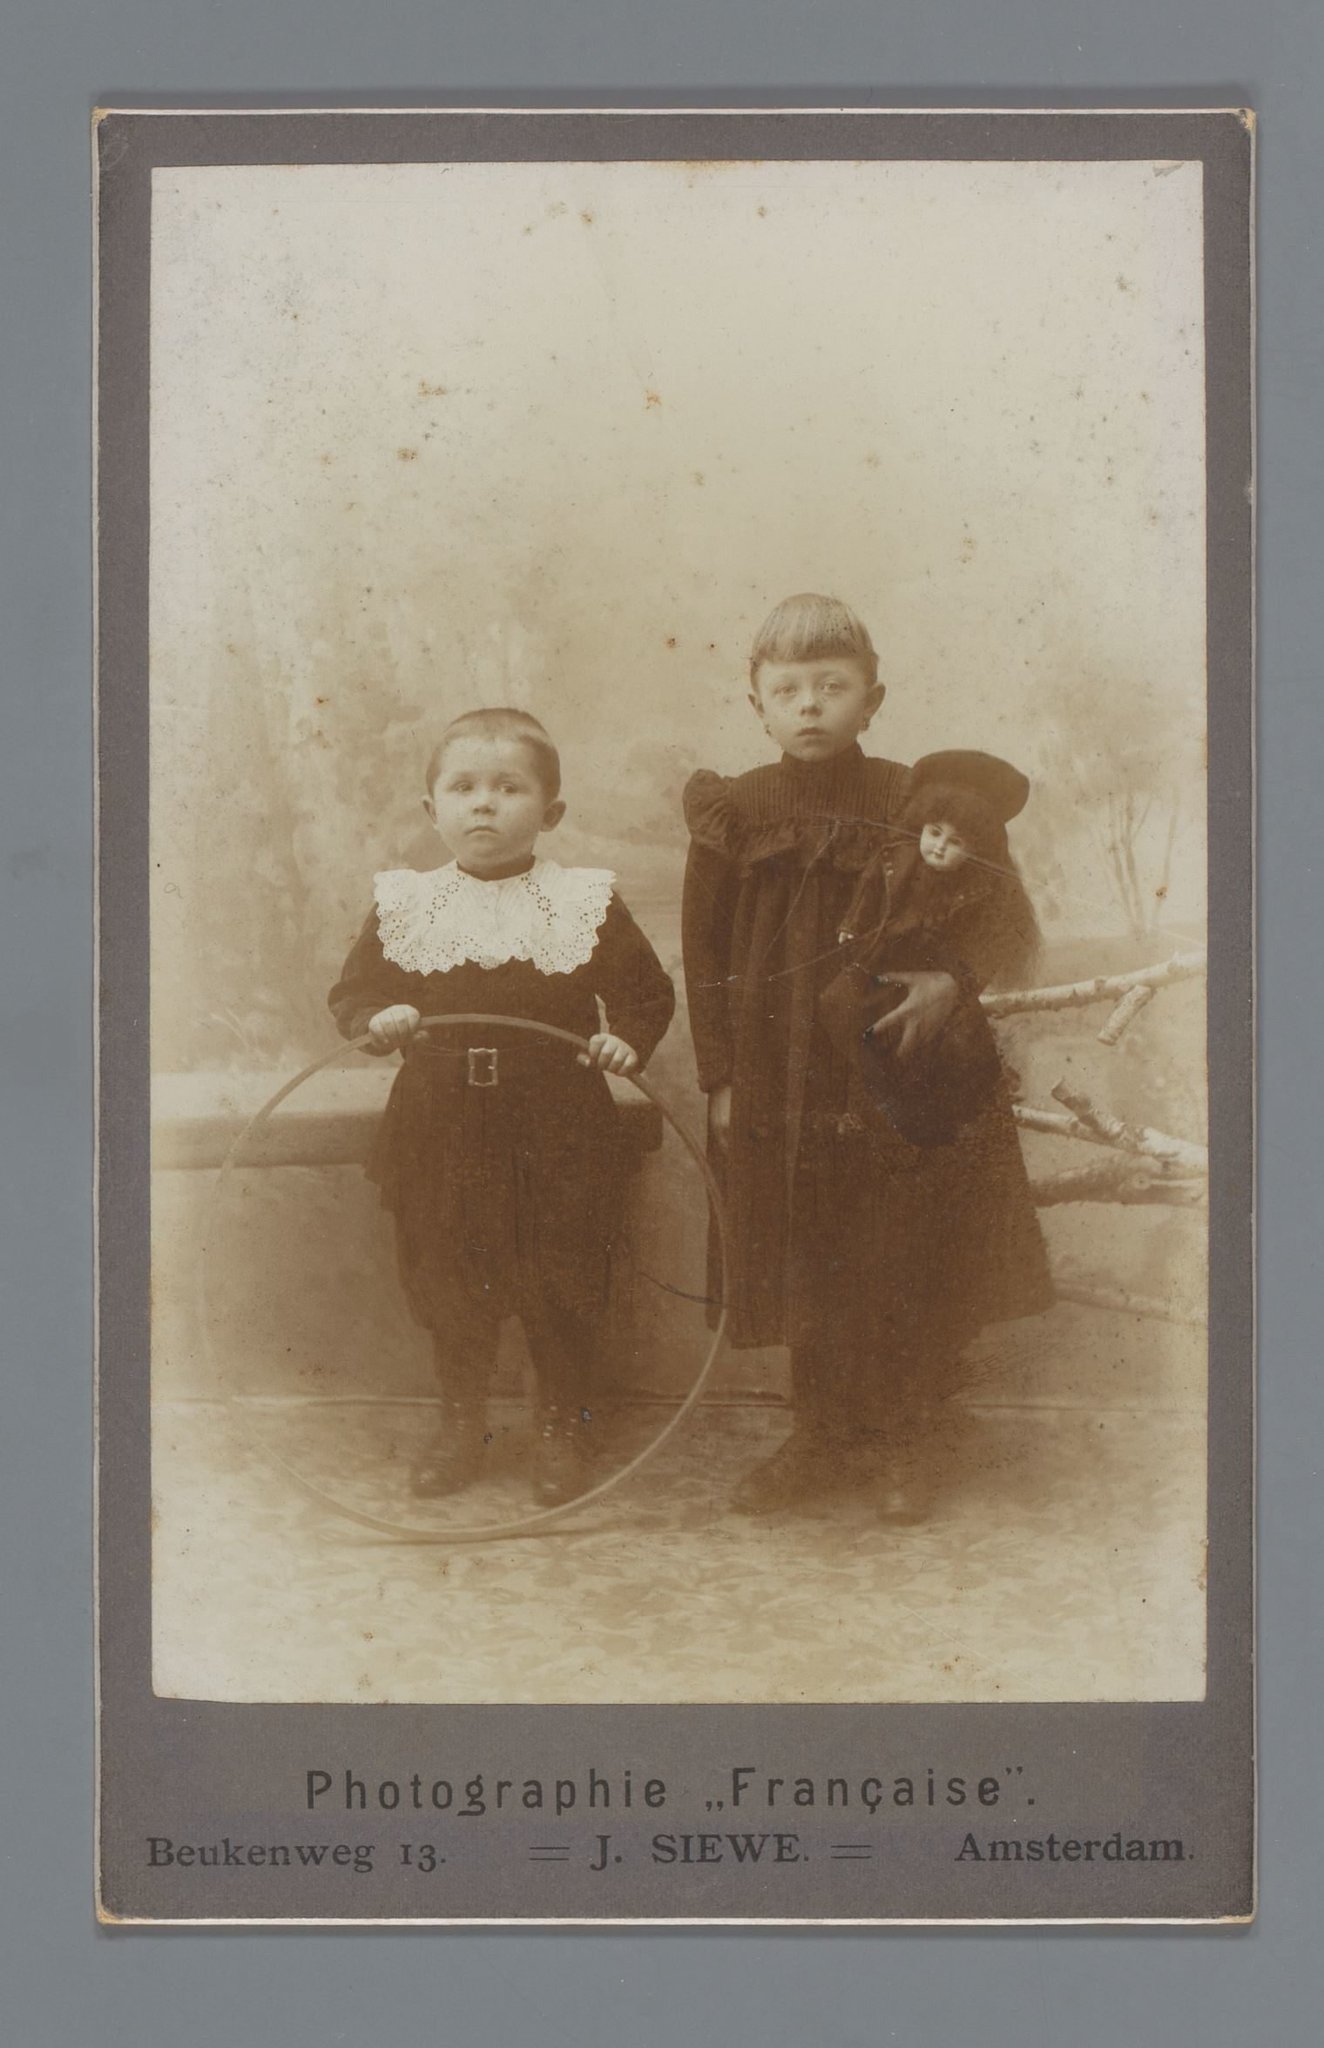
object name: cabinet photograph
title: Photographie ,,Française"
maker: j. siewe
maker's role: fotograaf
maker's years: 1873-1905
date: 1895-1915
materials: cardboard, photographic support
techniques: gelatin silver print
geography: amsterdam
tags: child, (playing with) dolls